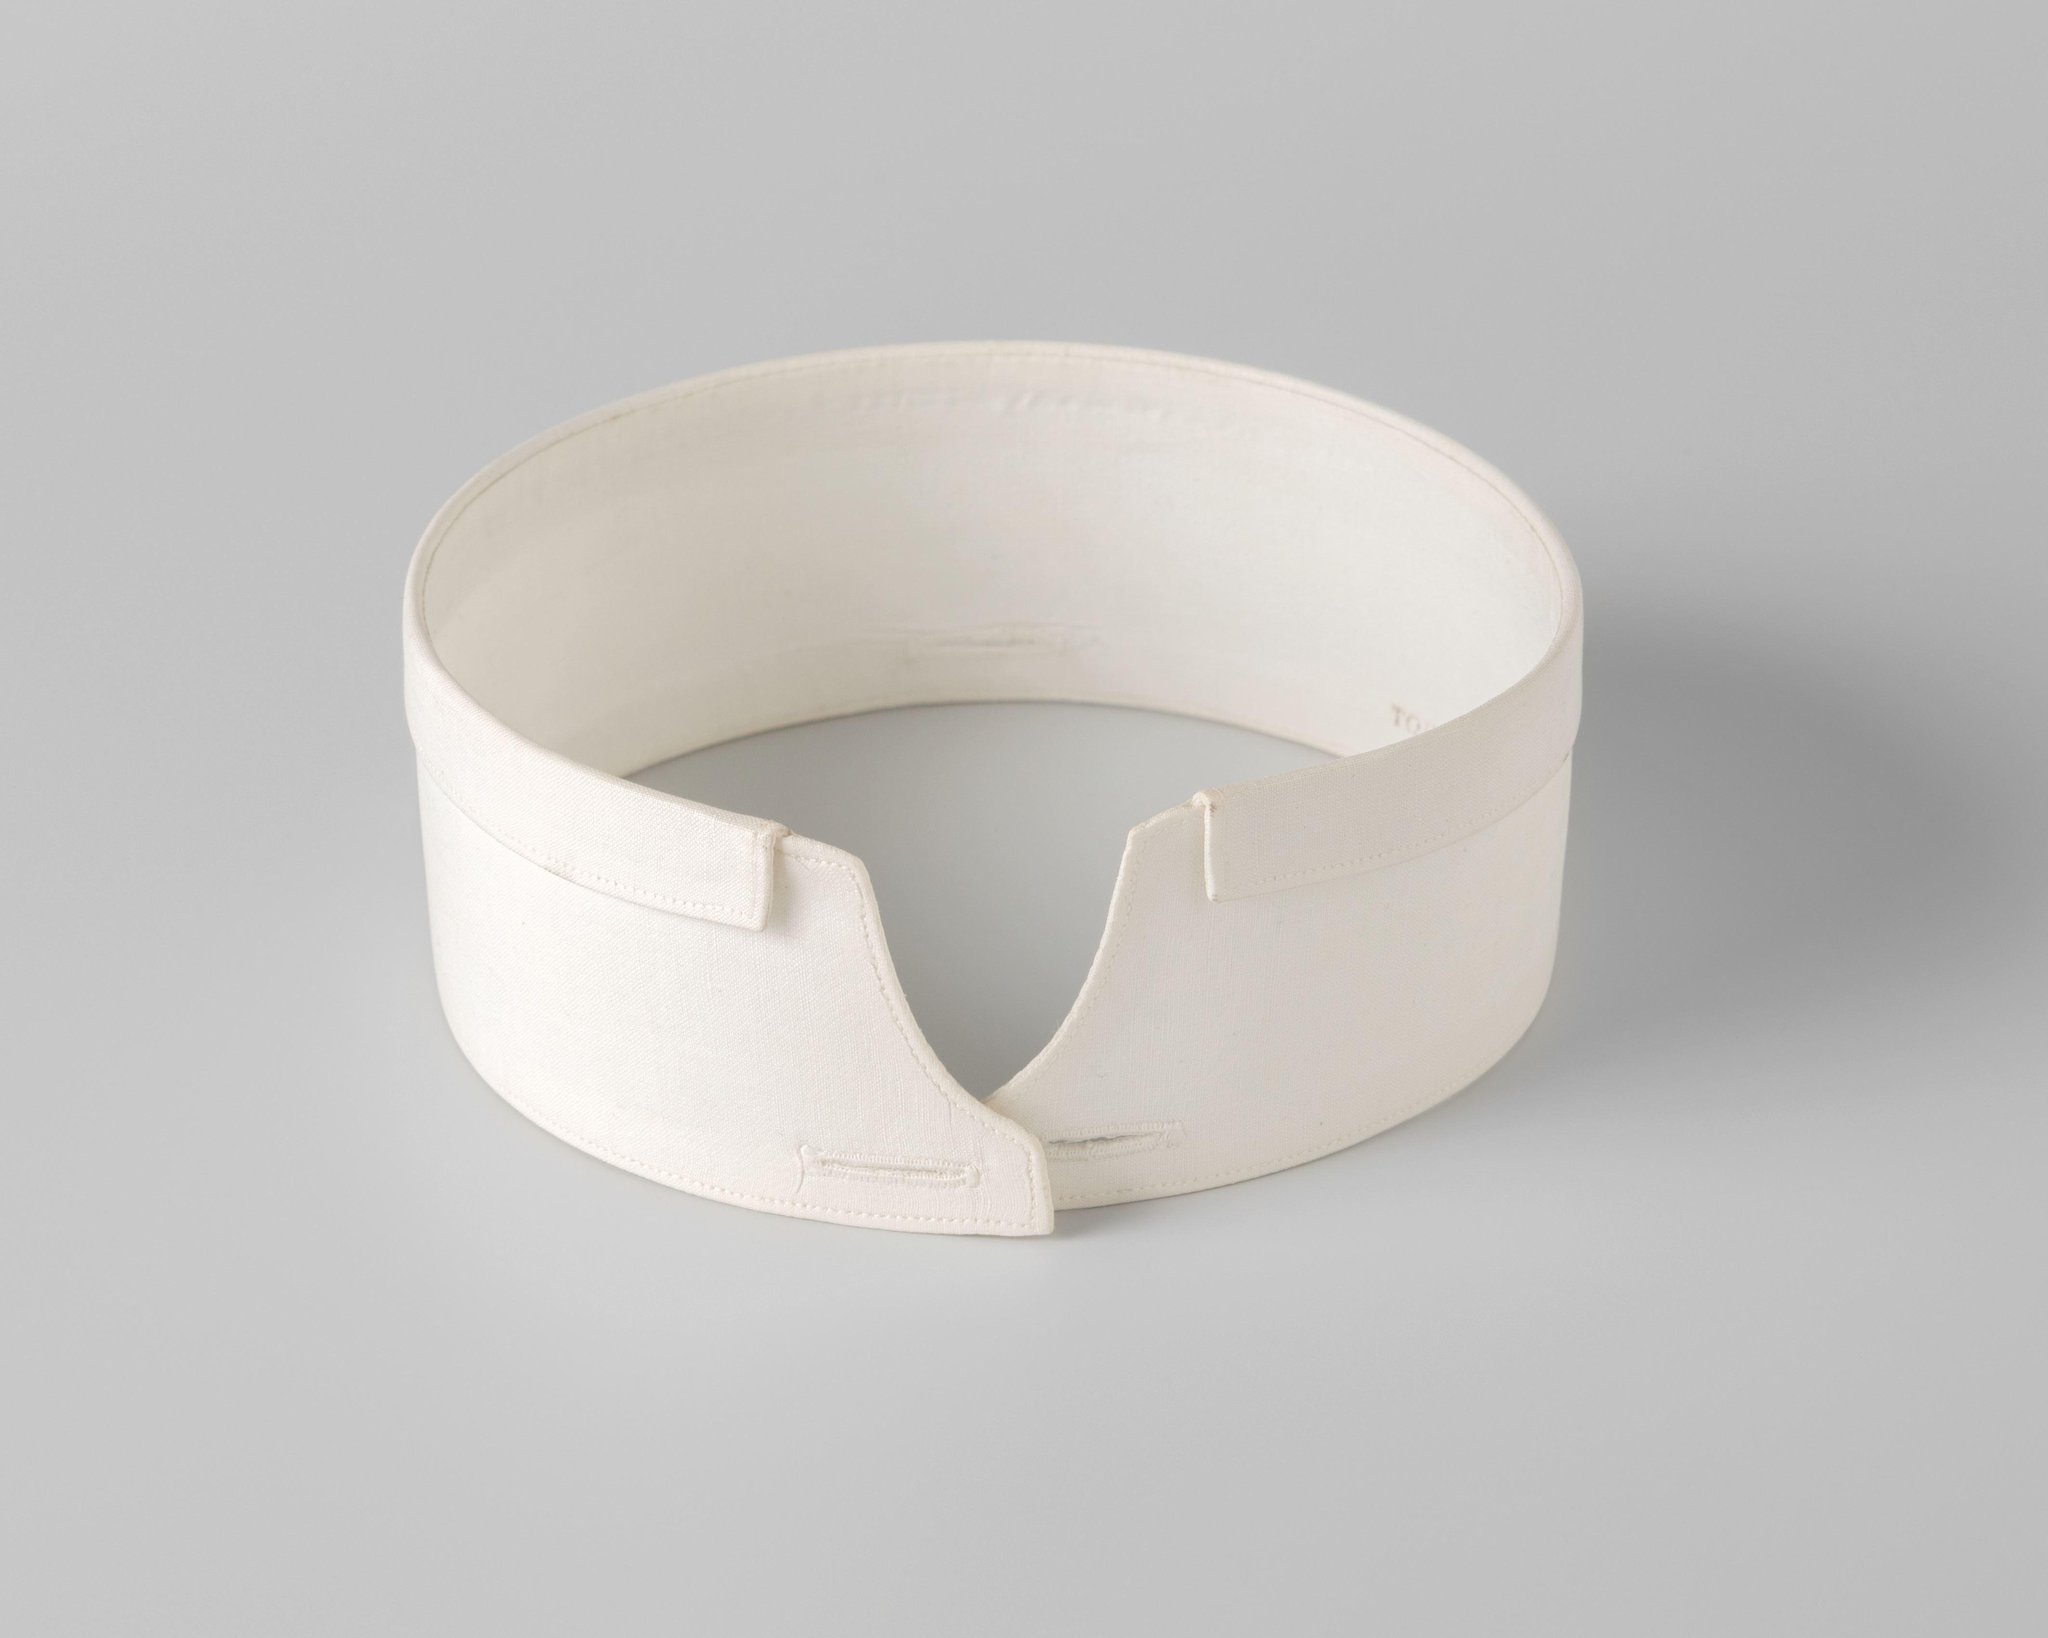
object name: band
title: Boord van linnen, horend bij een amazonekostuum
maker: Anonymous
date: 1895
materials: linen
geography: france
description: Boord van linnen, horend bij een amazonekostuum. Met smalle omslag en TOILE MARGUERITE 35. Bewaard in een met turquoise moiré-papier beplakte doos met adres MARGUERITE 35.